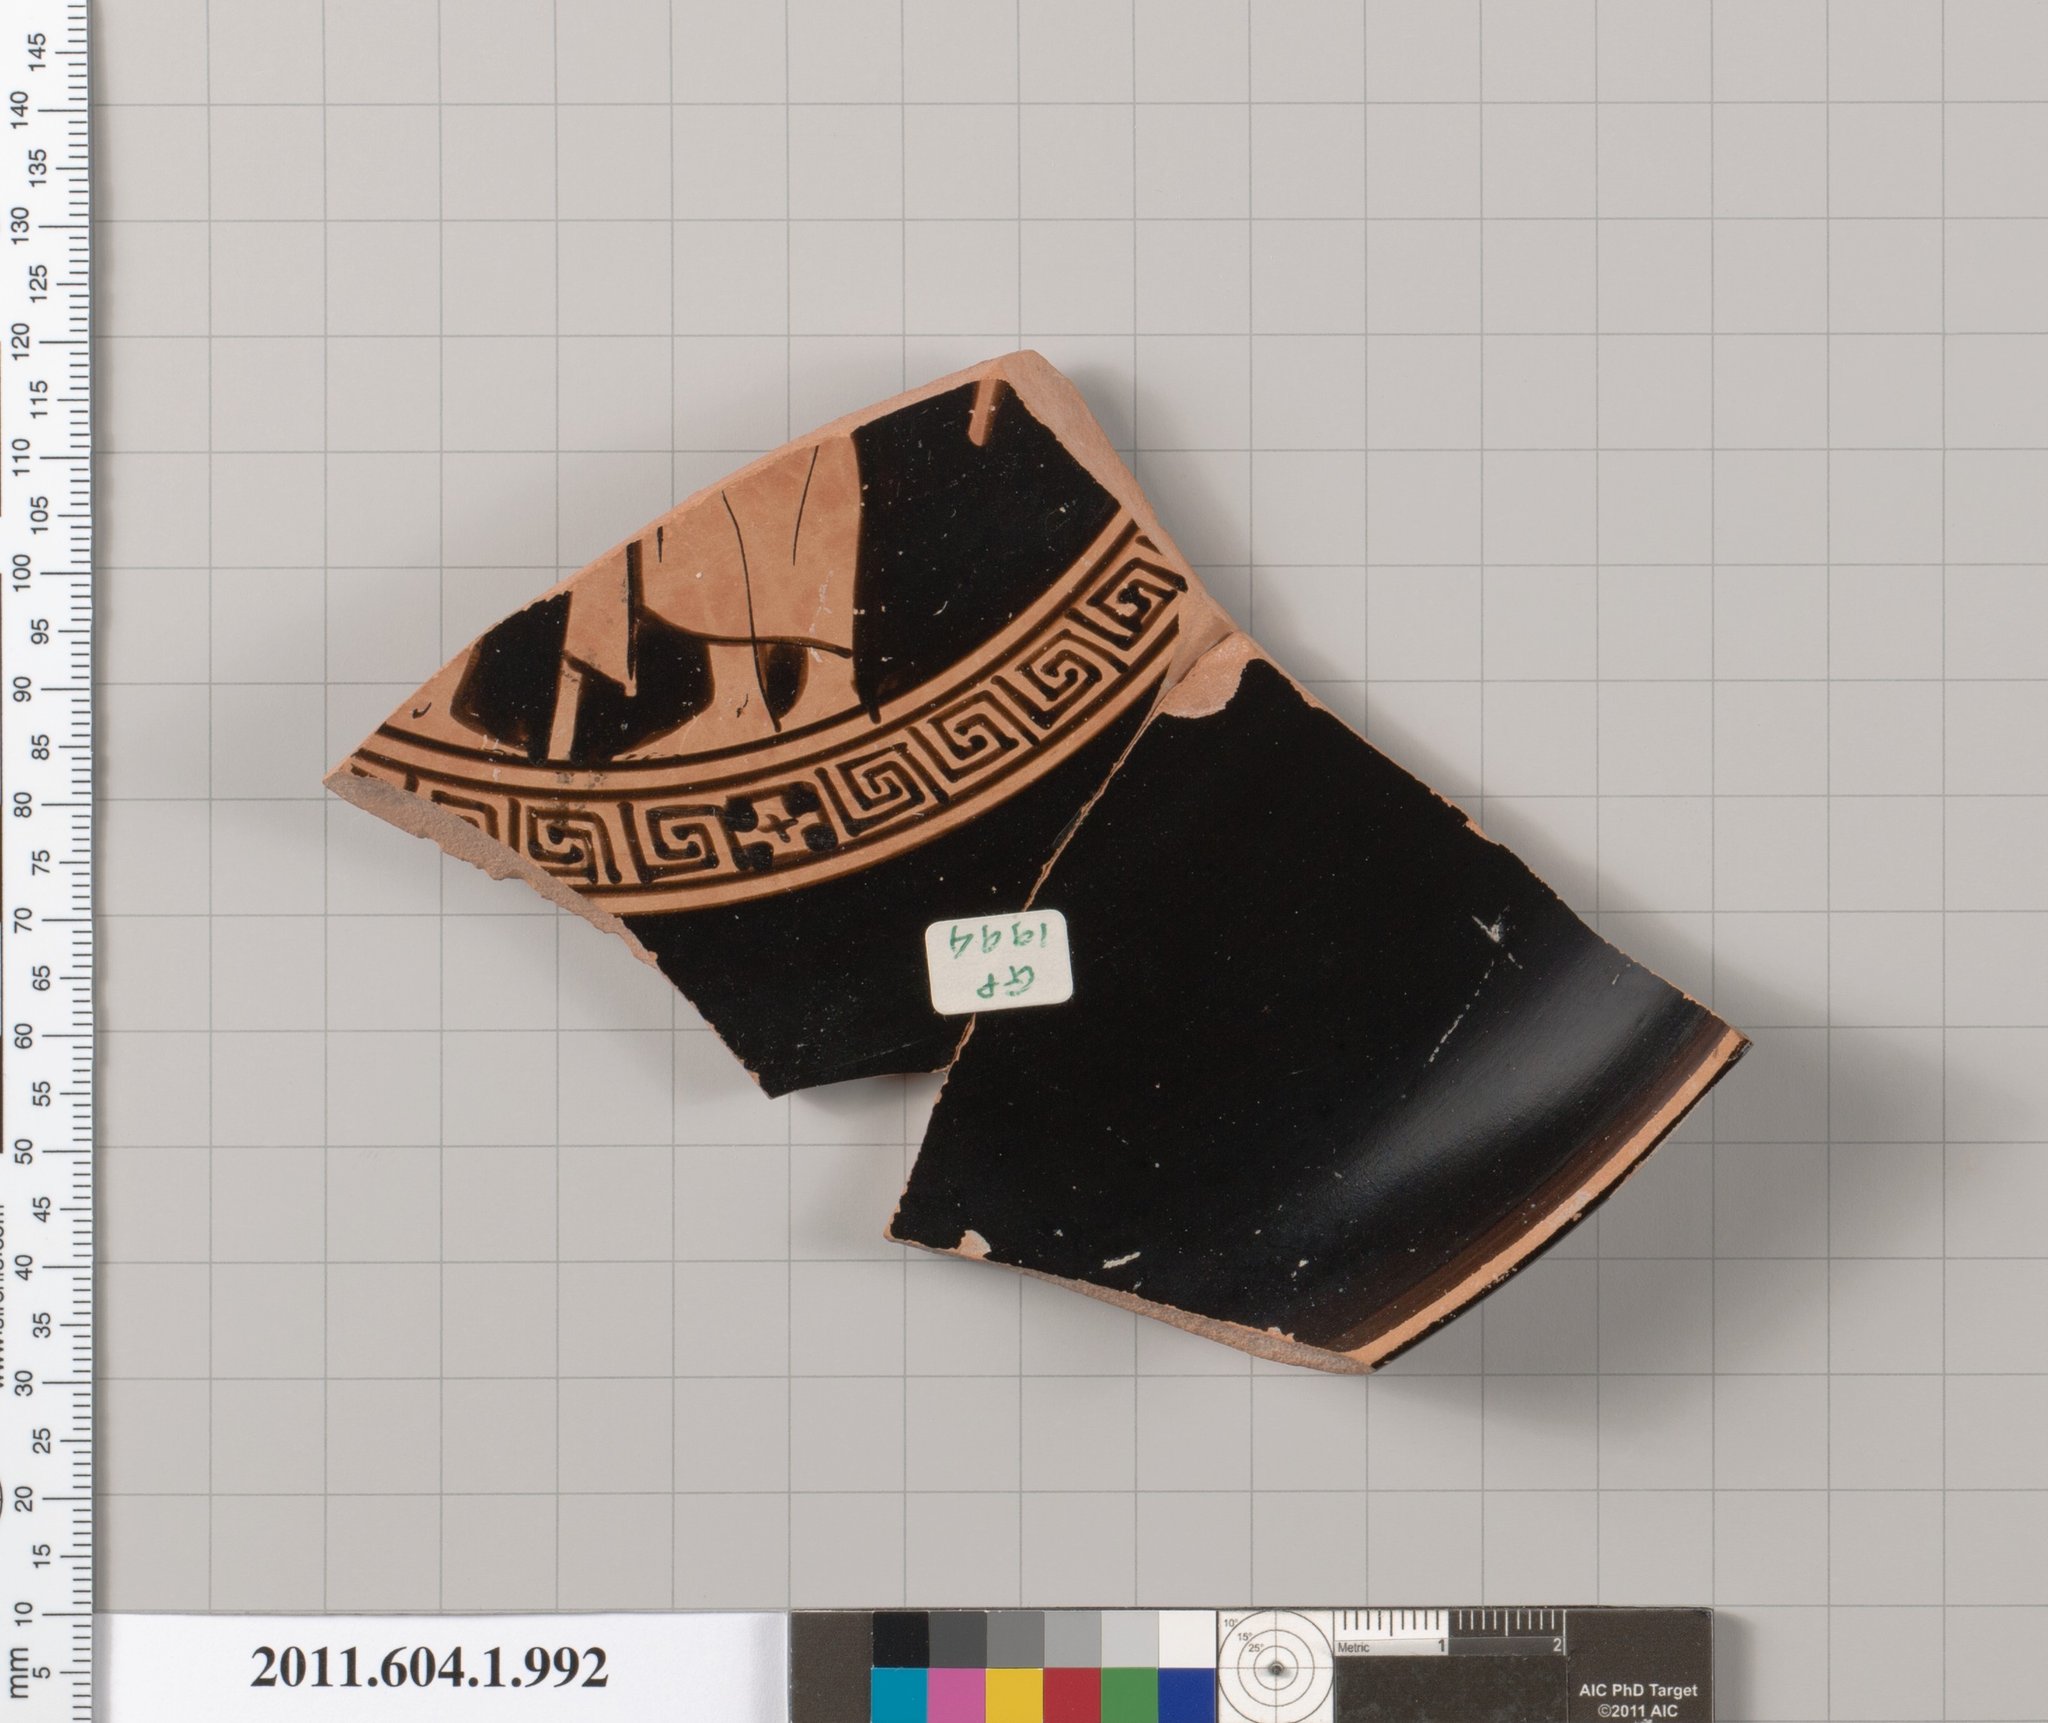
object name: kylix fragment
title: Terracotta fragment of a kylix (drinking cup)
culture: greek, attic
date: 475-451 BCE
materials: terracotta